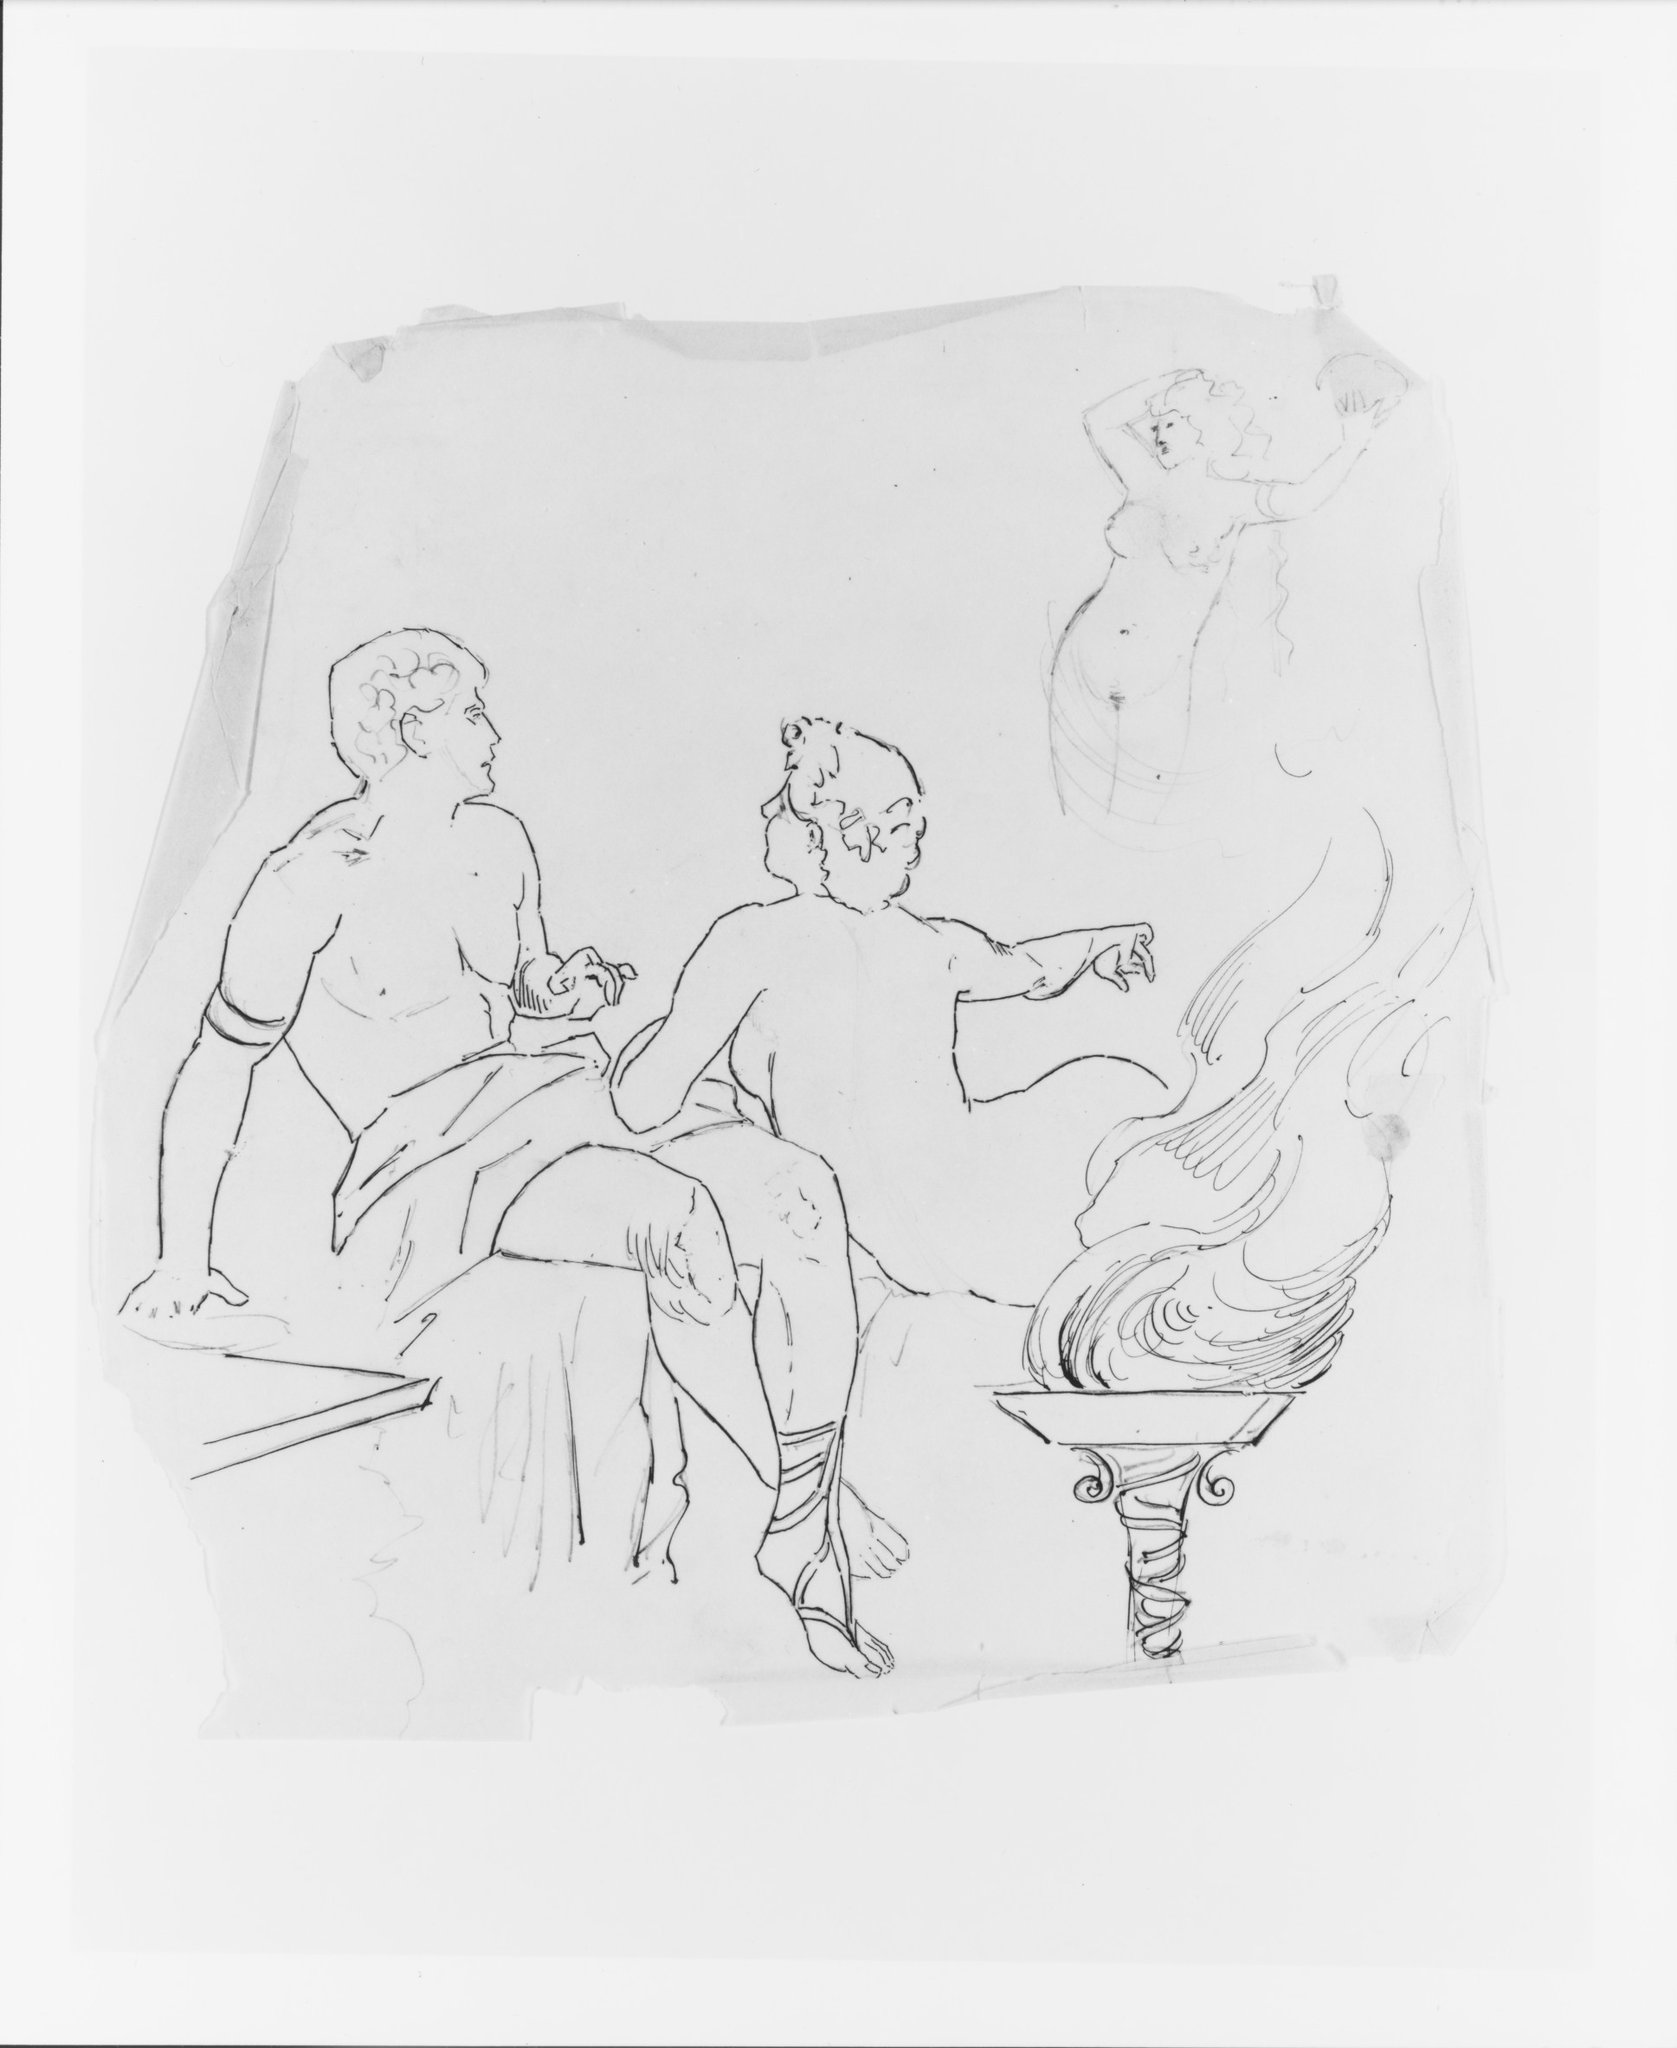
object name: drawing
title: Mythological Figure Group (from Sketchbook)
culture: american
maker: john quincy adams ward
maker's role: artist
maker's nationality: american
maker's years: 1830-1910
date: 1860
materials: graphite, paper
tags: men,female nudes